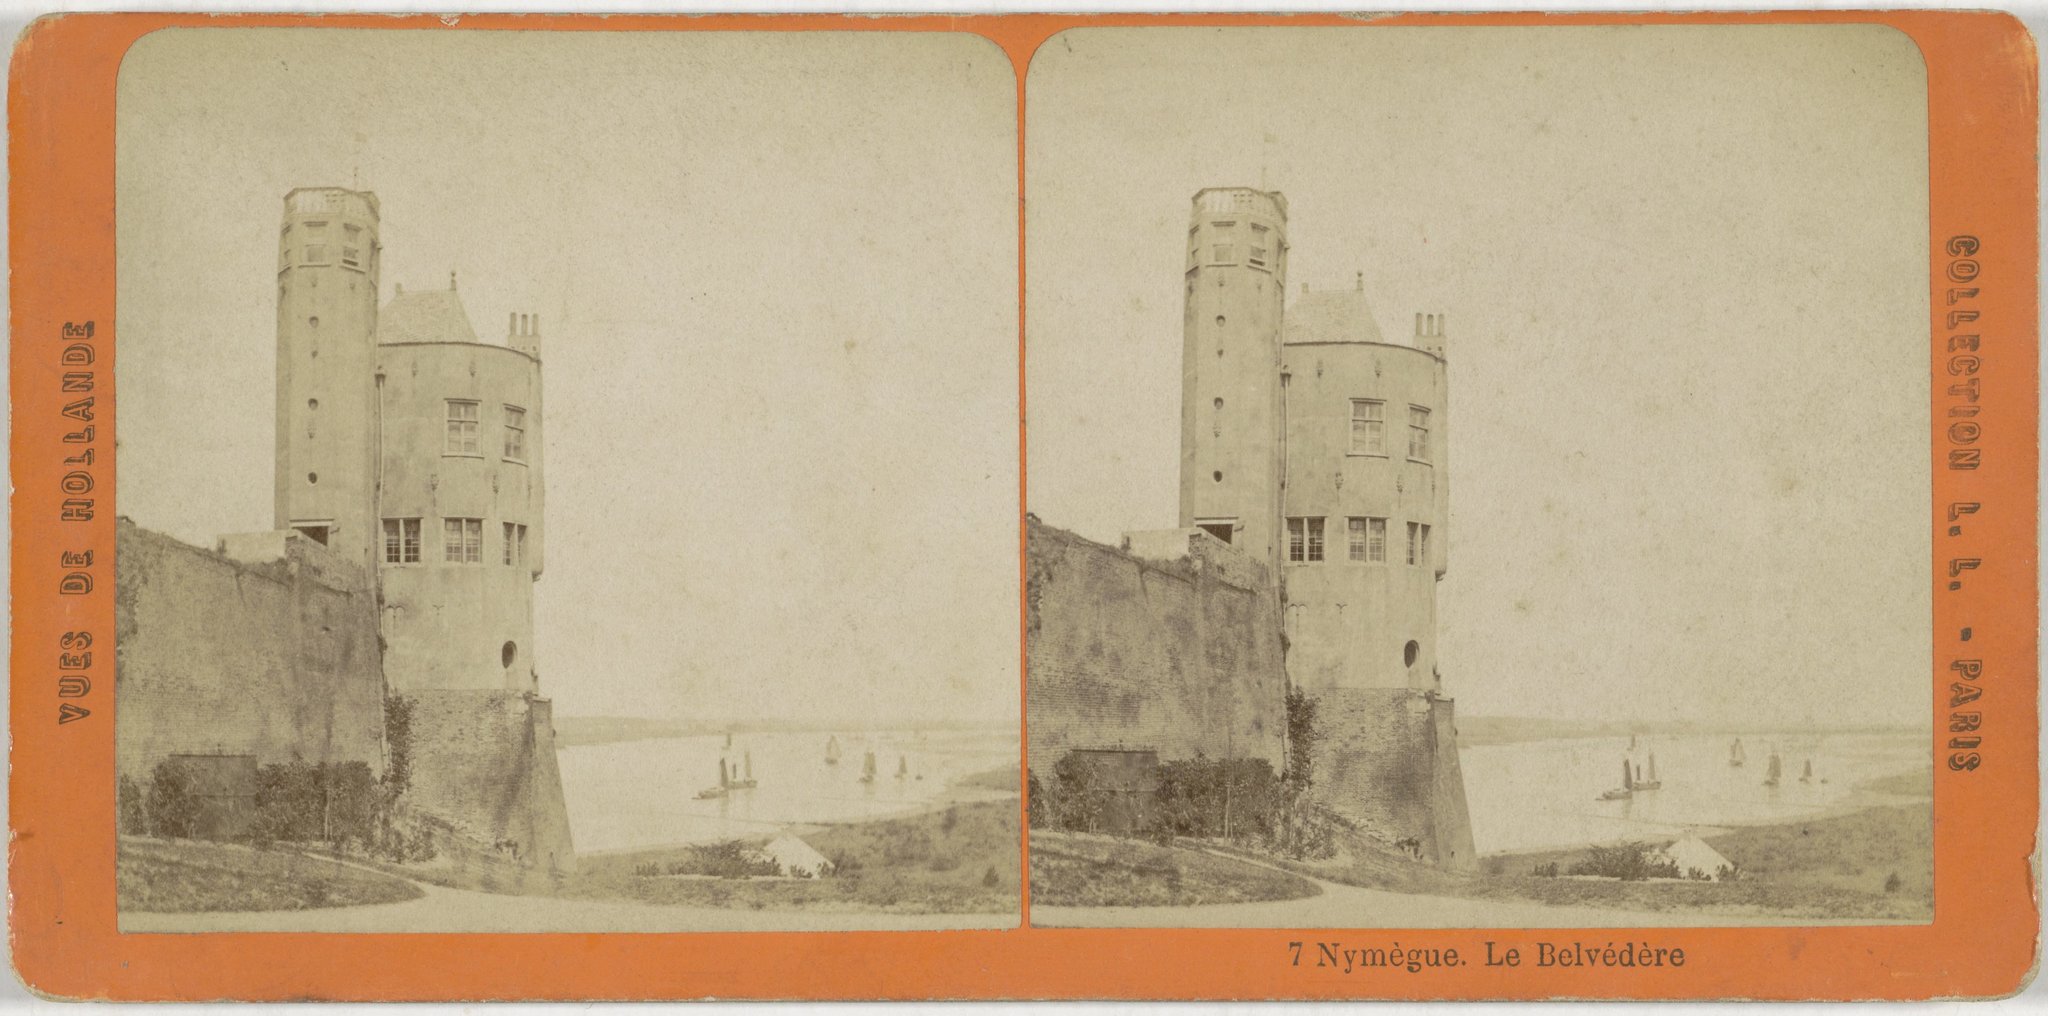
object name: stereograph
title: Vues de Hollande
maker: Anonymous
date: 1873-1890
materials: cardboard, paper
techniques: albumen print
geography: nijmegen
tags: landscape with tower or castle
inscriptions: number: ‘7’